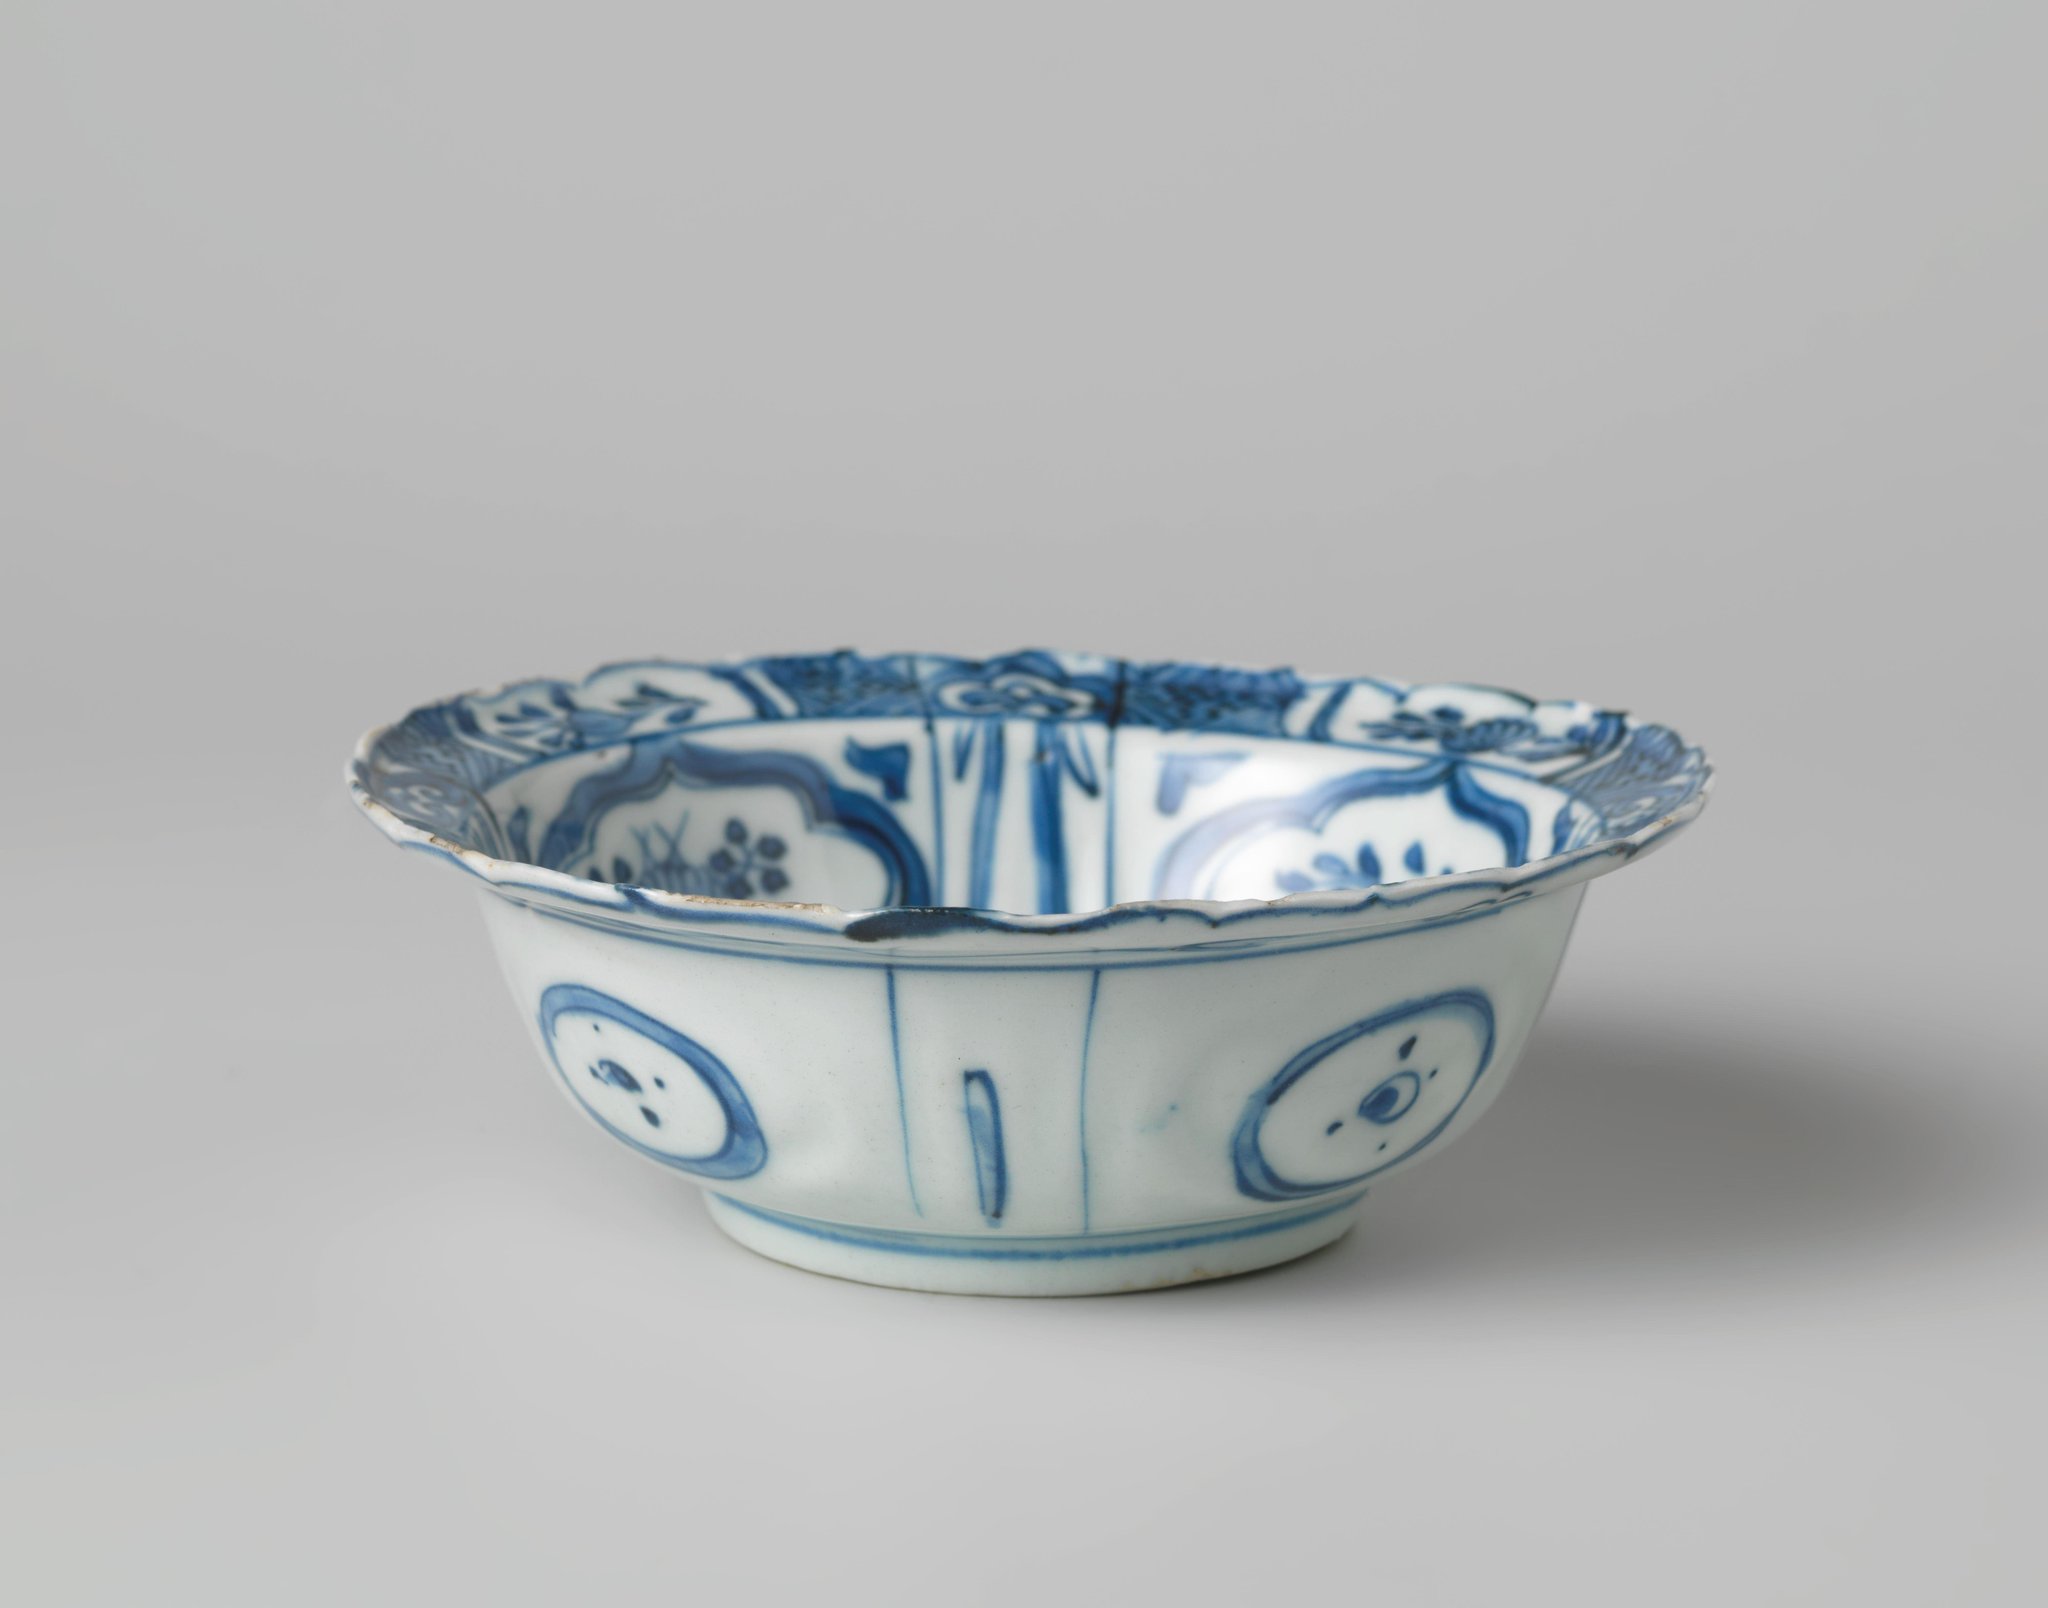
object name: bowl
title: Klapmuts bowl with a rock, flowering plants and flower sprays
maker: Anonymous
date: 1600-1649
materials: cobalt, glaze, paint, porcelain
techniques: firing, turning, vitrification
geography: china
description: Klapmutskom gedecoreerd in onderglazuur blauw, met in het plat bloeiende planten en bamboe bij een rots, en een decoratie in vakken met bloeiende planten en geluksymbolen op de wand en rand.